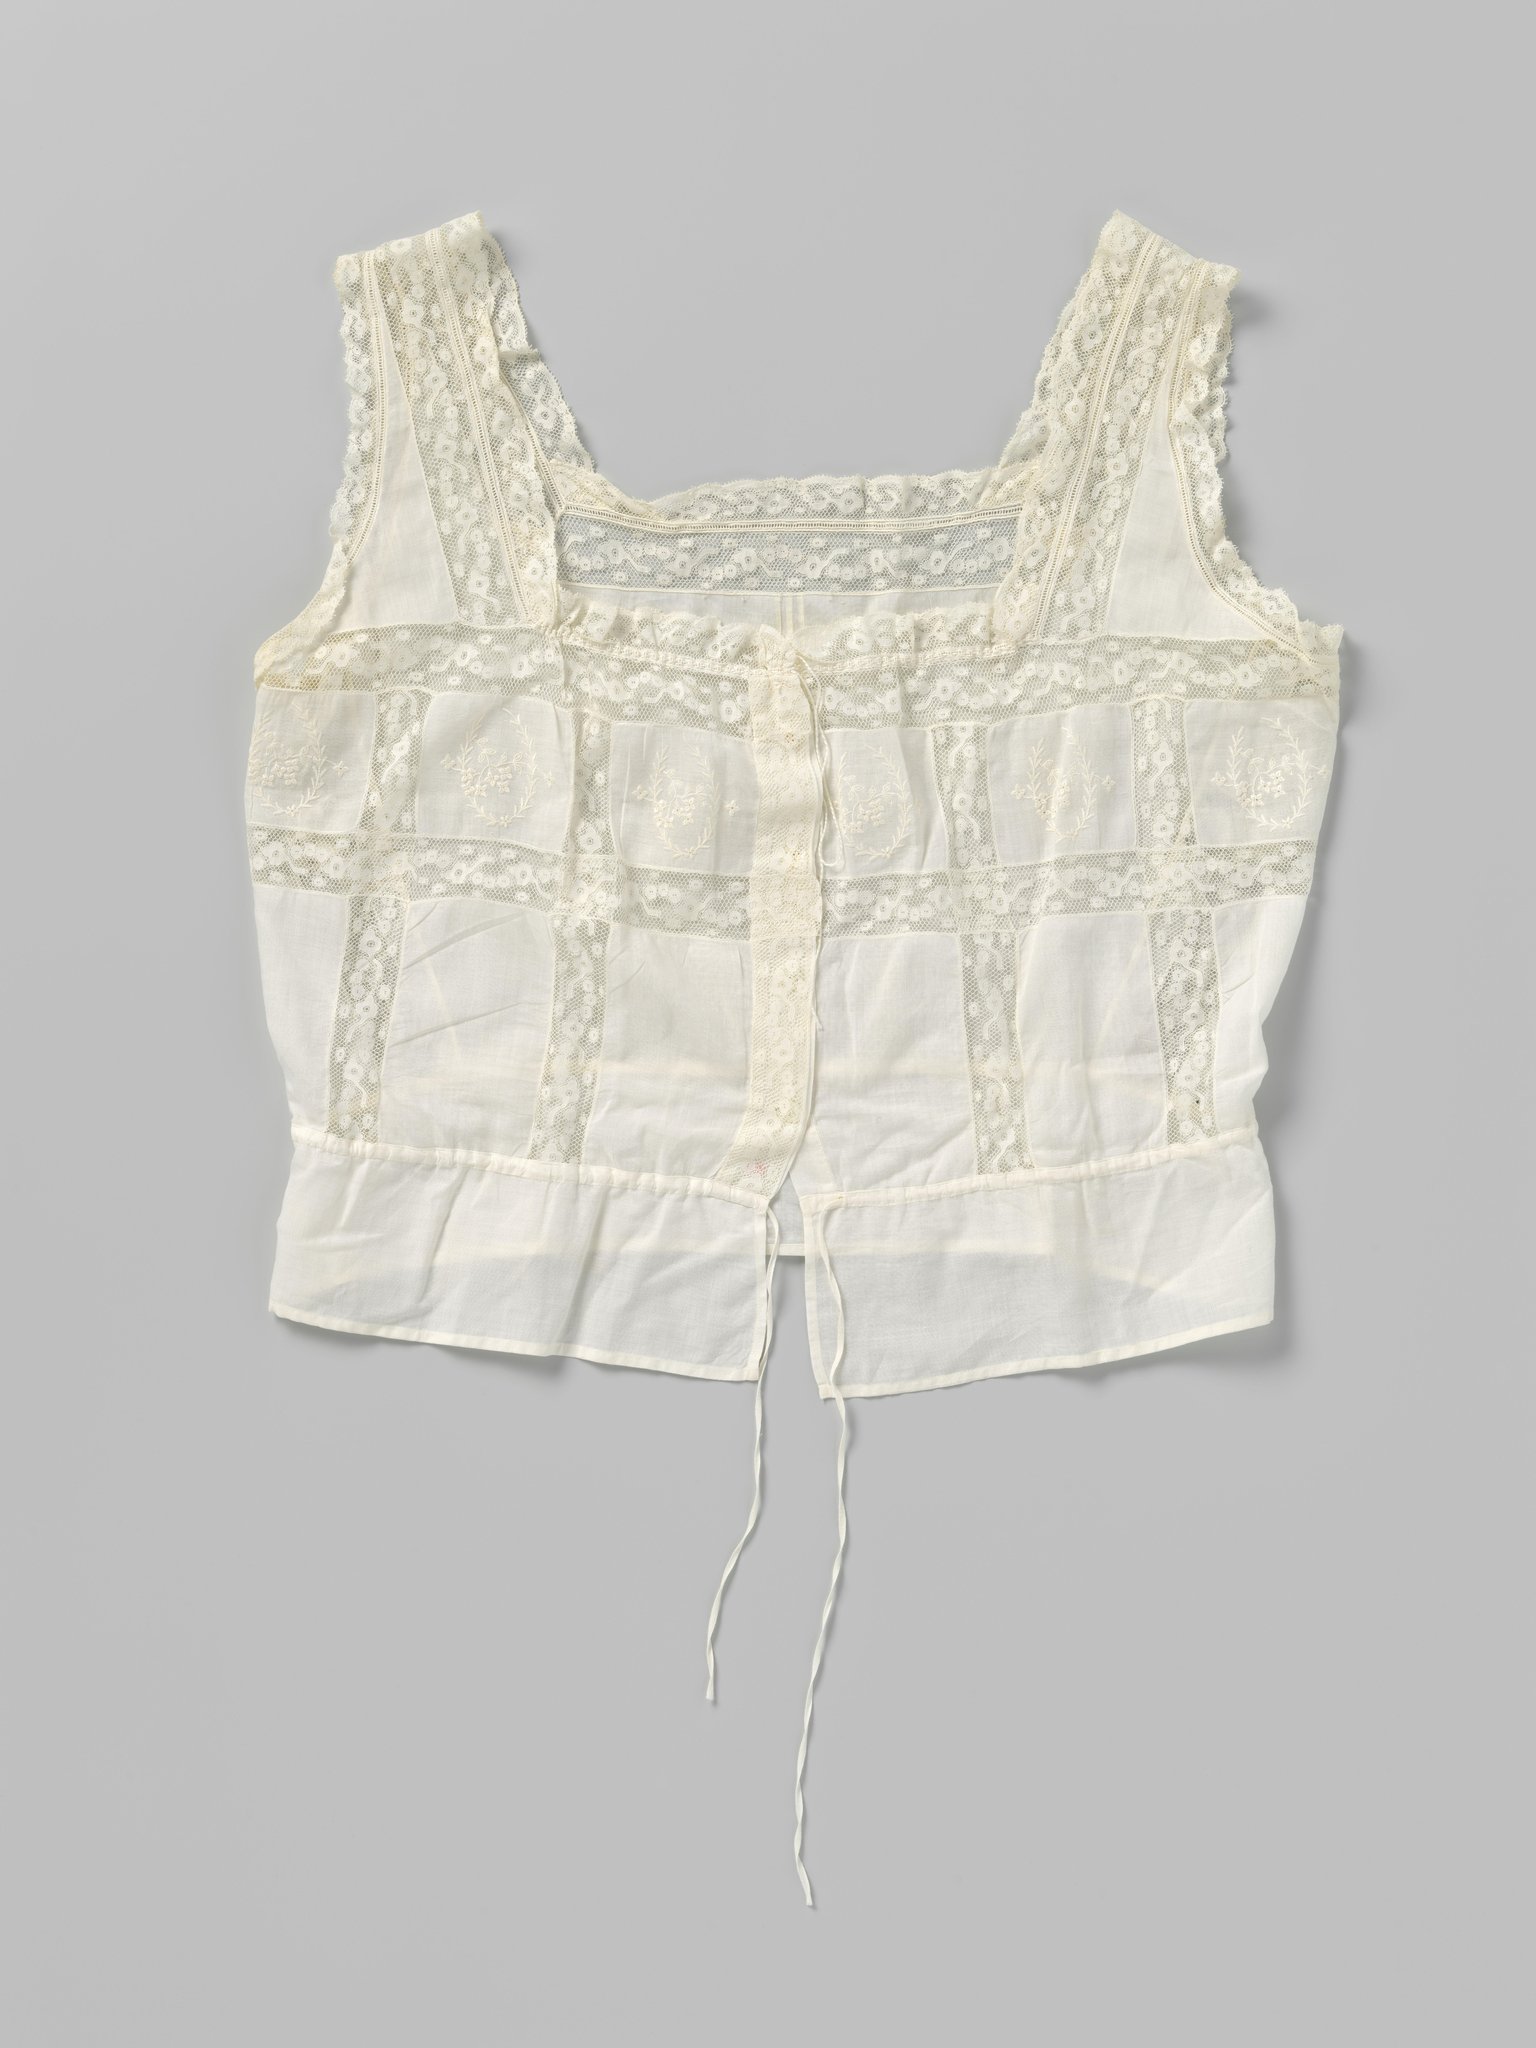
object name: onderlijfje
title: Corset cover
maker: Anonymous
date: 1890-1910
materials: textile, cotton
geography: switzerland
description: From the moment the hoop skirt (crinoline) went out of fashion in Paris in the 1860s, Dutch women had their metal hoops bent backwards into an oval by the blacksmith. A long, slender silhouette with emphasis on the buttocks was now expected and so the bustle (tournure) began its rise, sometimes incorporated into a skirt but also as a loose piece fastened around the waist.